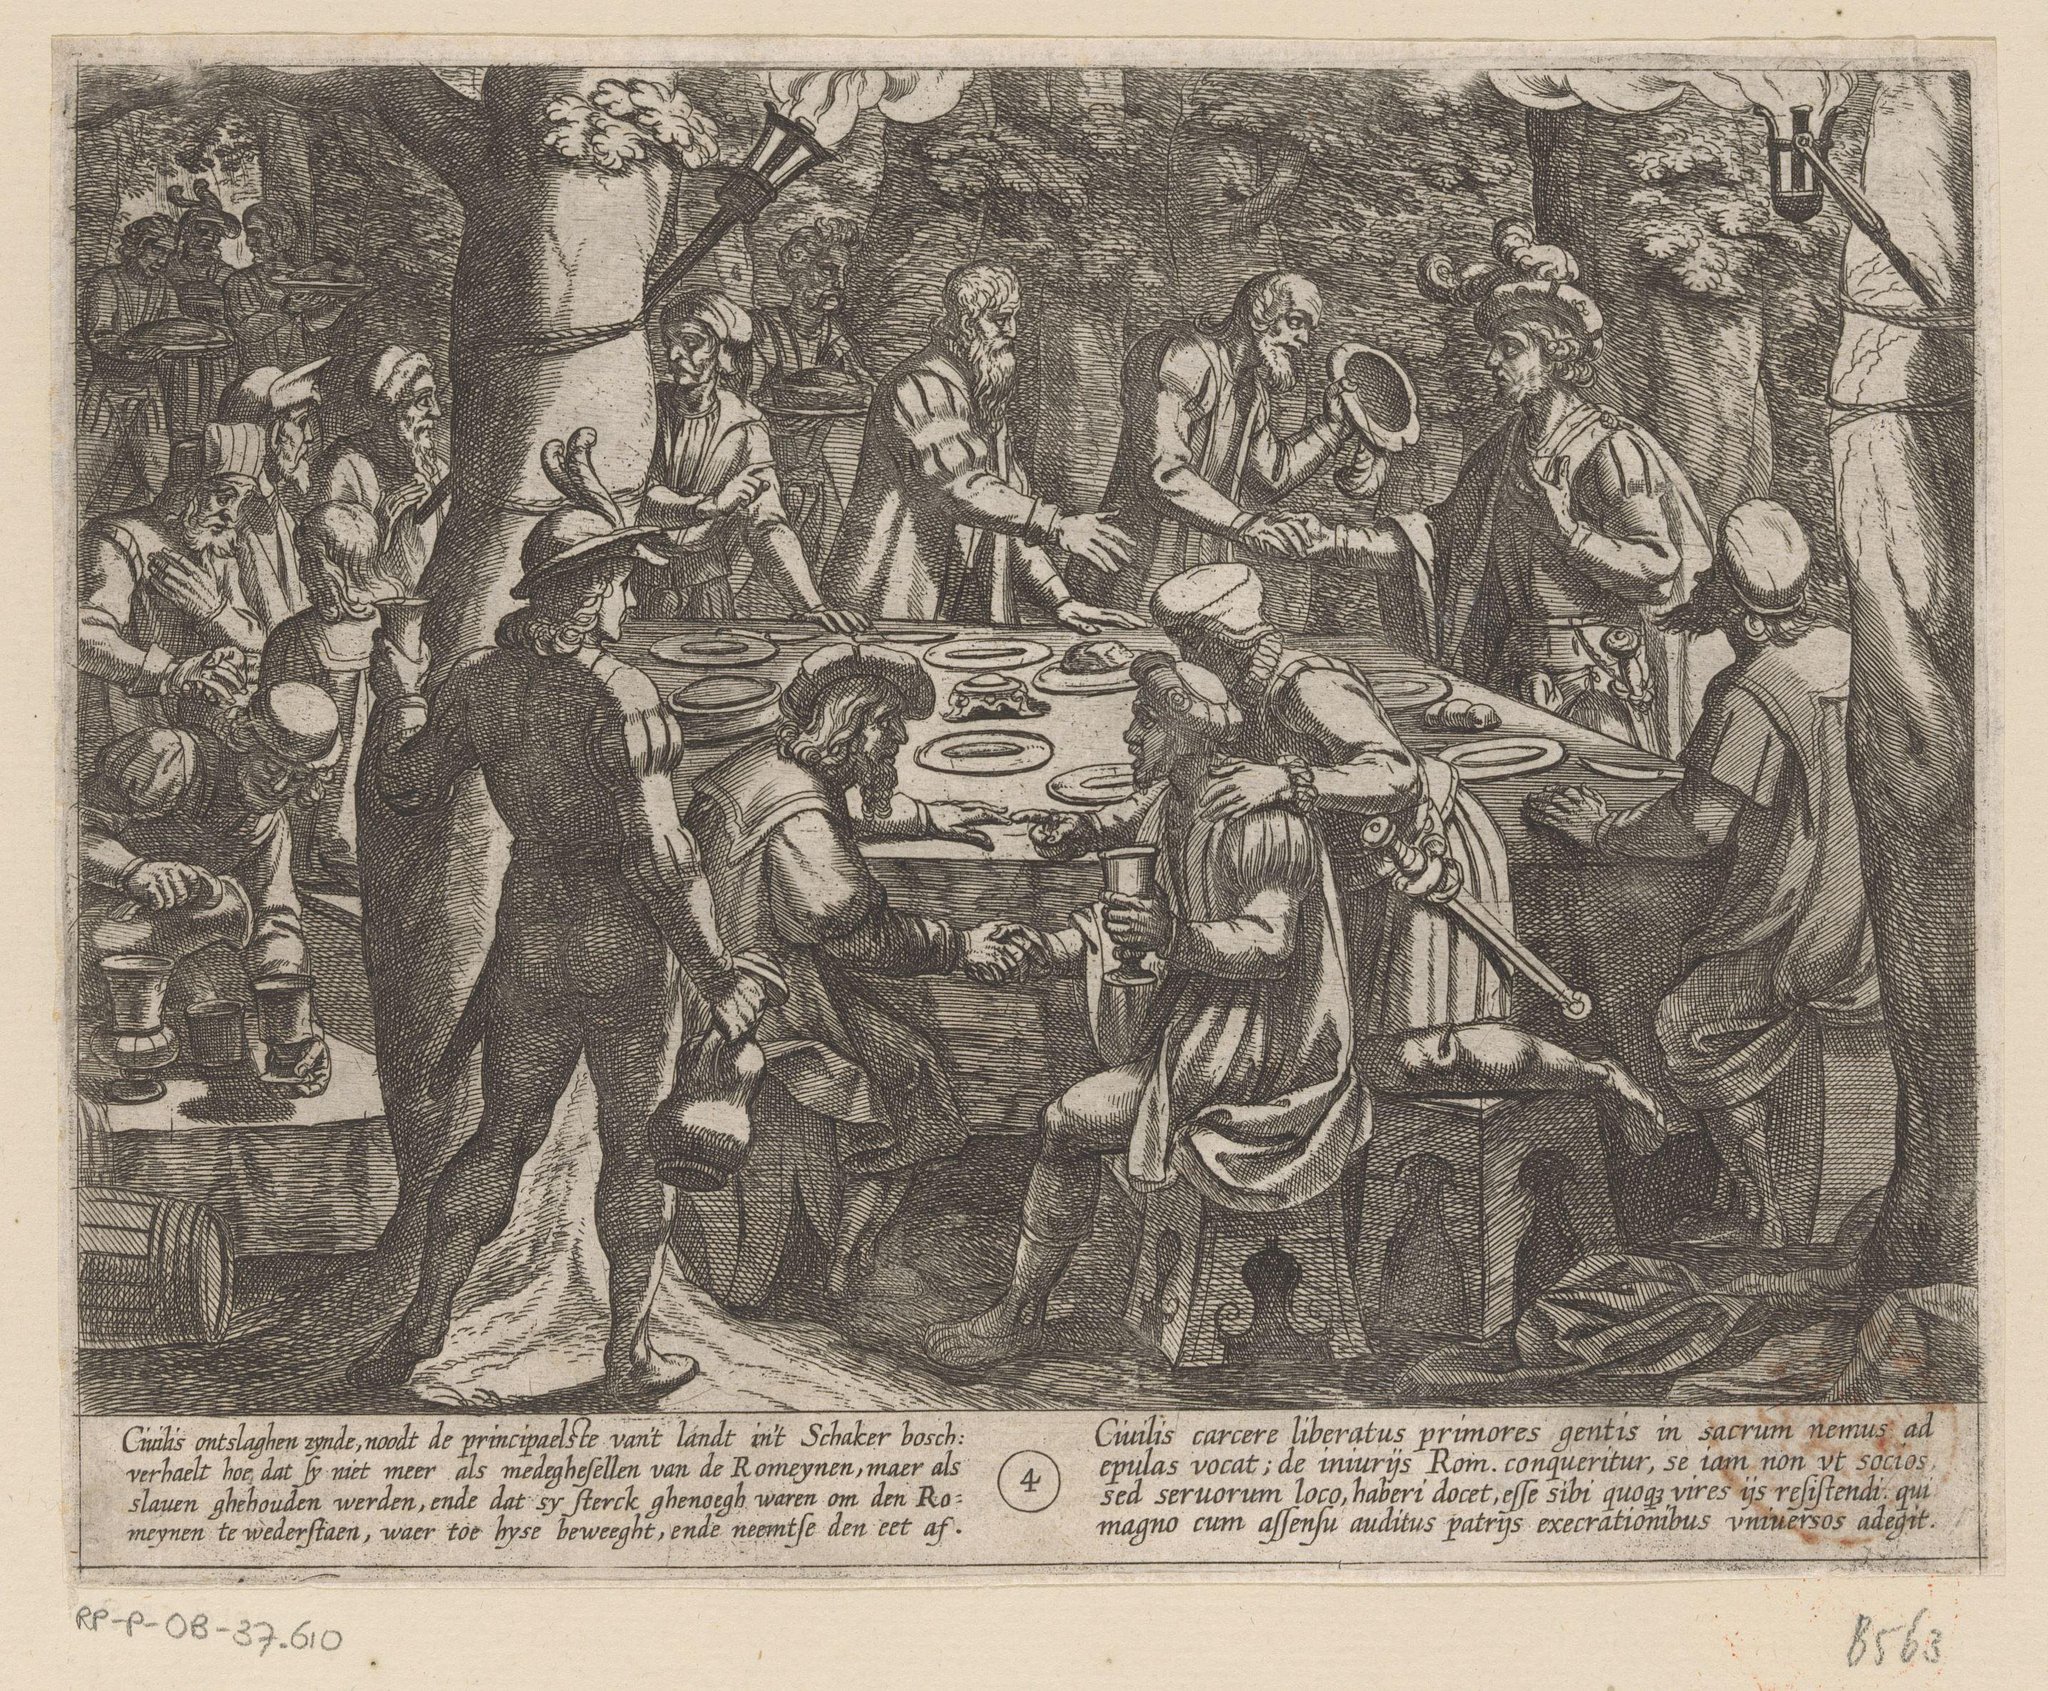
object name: print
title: Samenzwering van Julius Civilis, 69-70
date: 1611-1612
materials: paper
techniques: etching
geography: italy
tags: extinct, 'historical' peoples (with name), (story of) julius claudius civilis, netherlands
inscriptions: collector's mark: Lugt 240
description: De samenzwering van Julius Civilis in het Schakerbos. Julius Civilis vertelt de ouderlingen tijdens een nachtelijke bijeenkomst in het woud dat zij door de Romeinen als slaafgemaakten worden behandeld. Onderschrift in het Nederlands en in het Latijn.